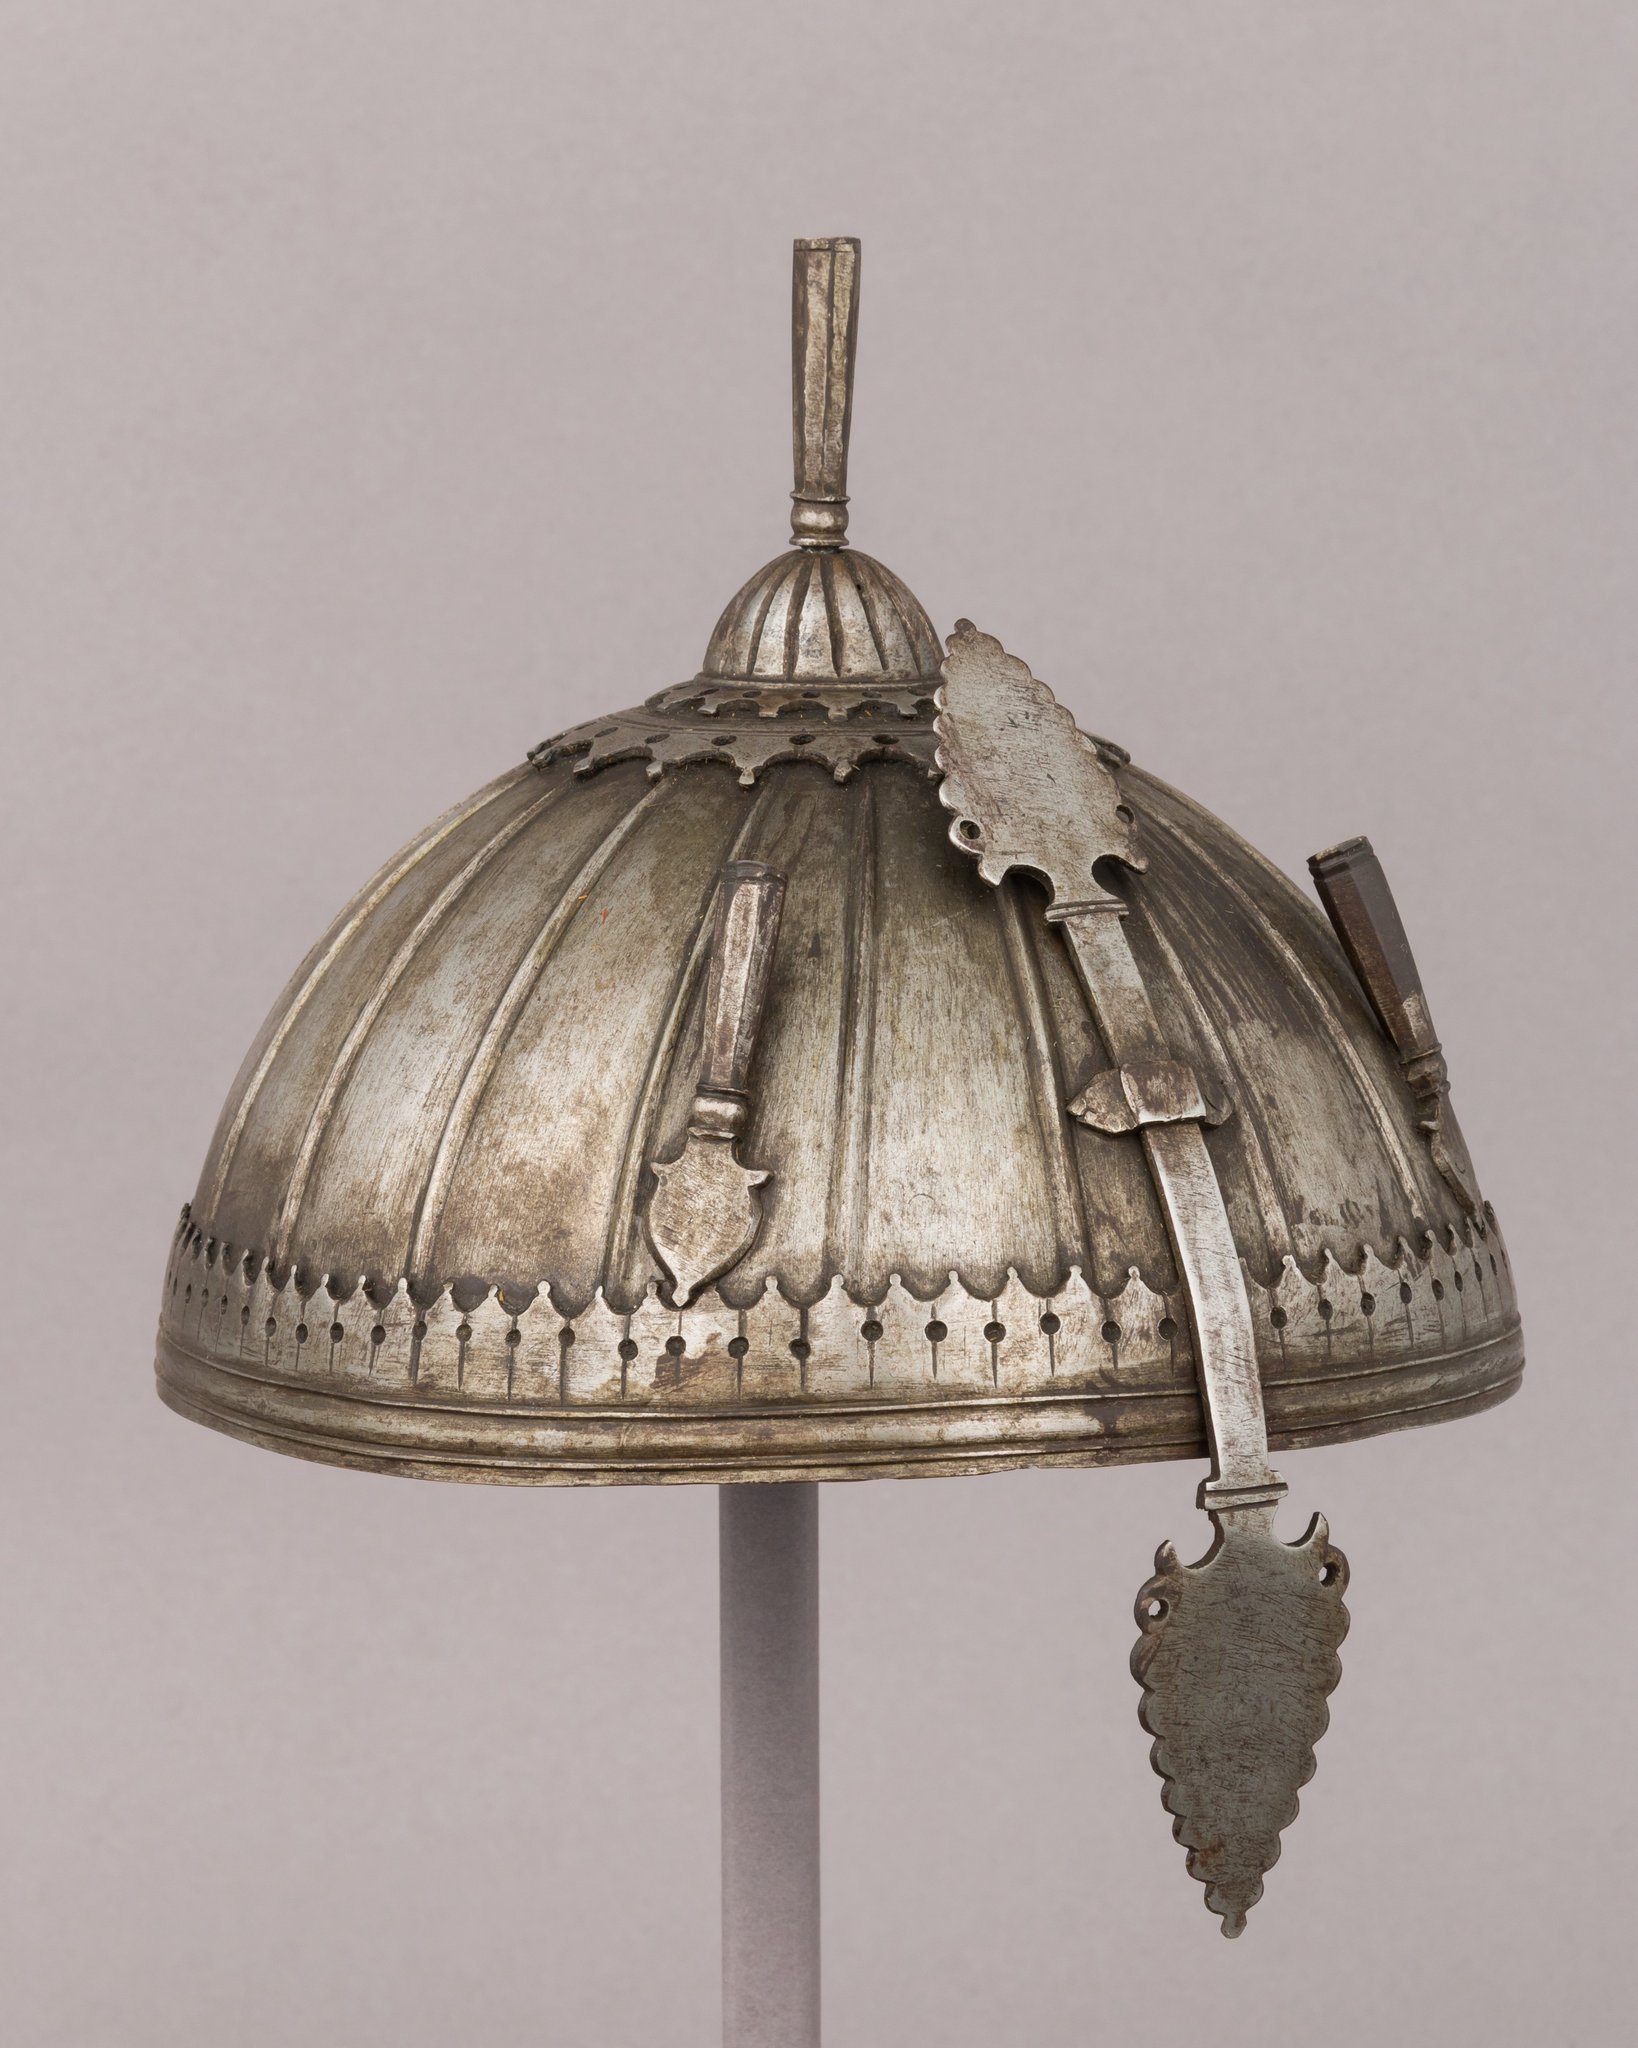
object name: helmet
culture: indian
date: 1701-1800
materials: steel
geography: india